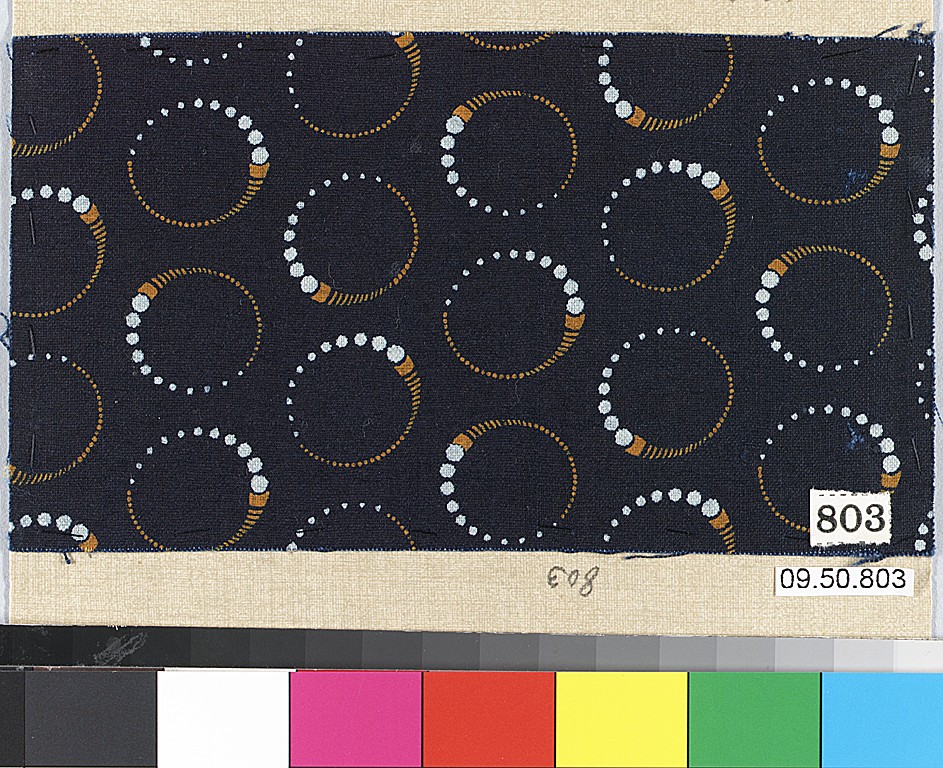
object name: piece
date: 1801-1900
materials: cotton